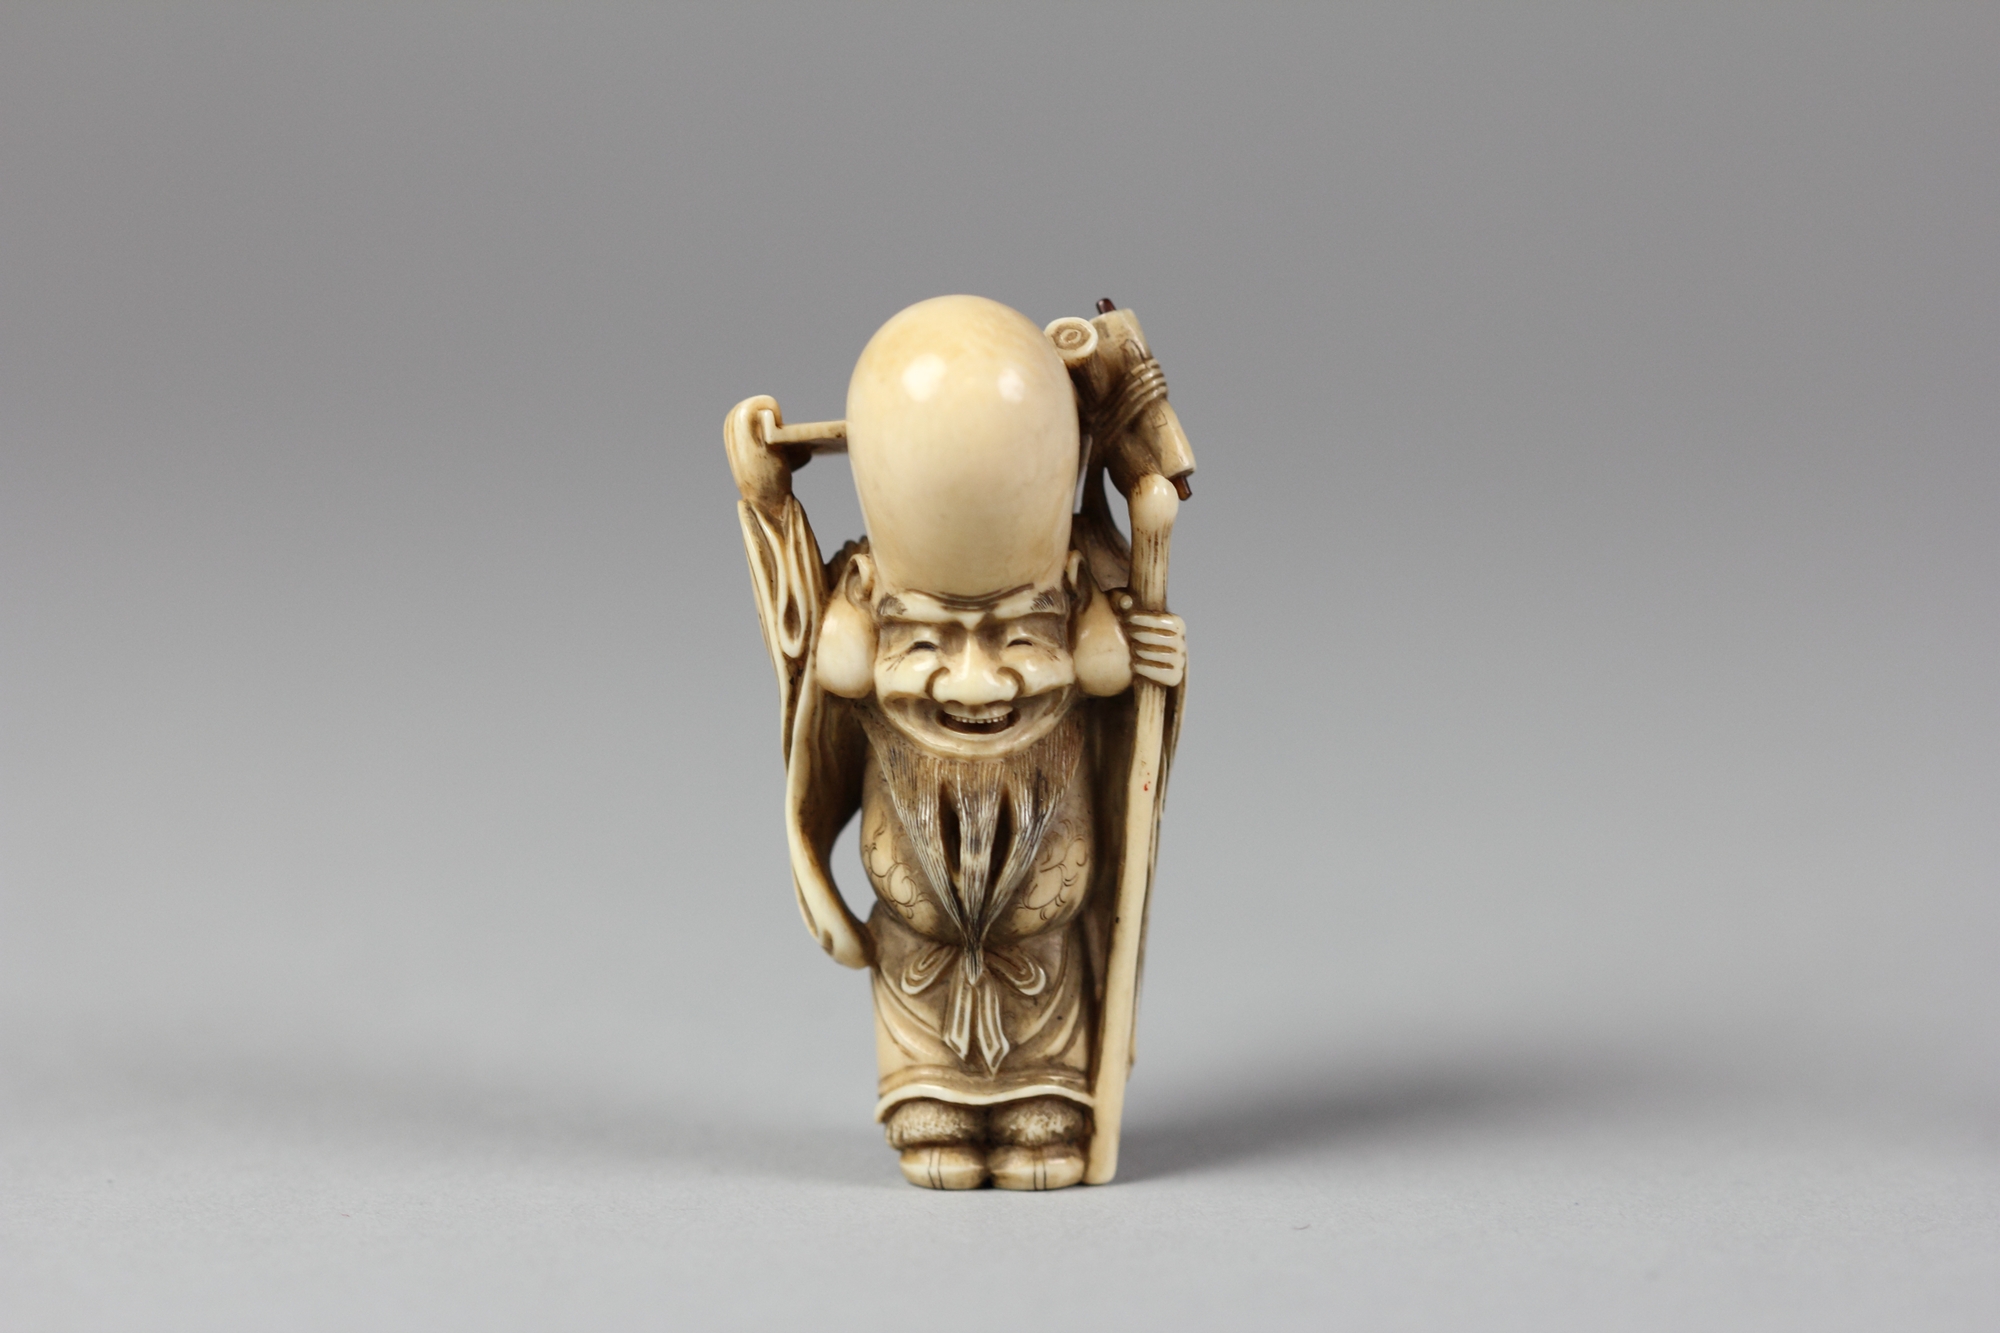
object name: netsuke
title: Netsuke of Fukurokujin with Karako Boy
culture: japanese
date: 1801-1900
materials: ivory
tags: men